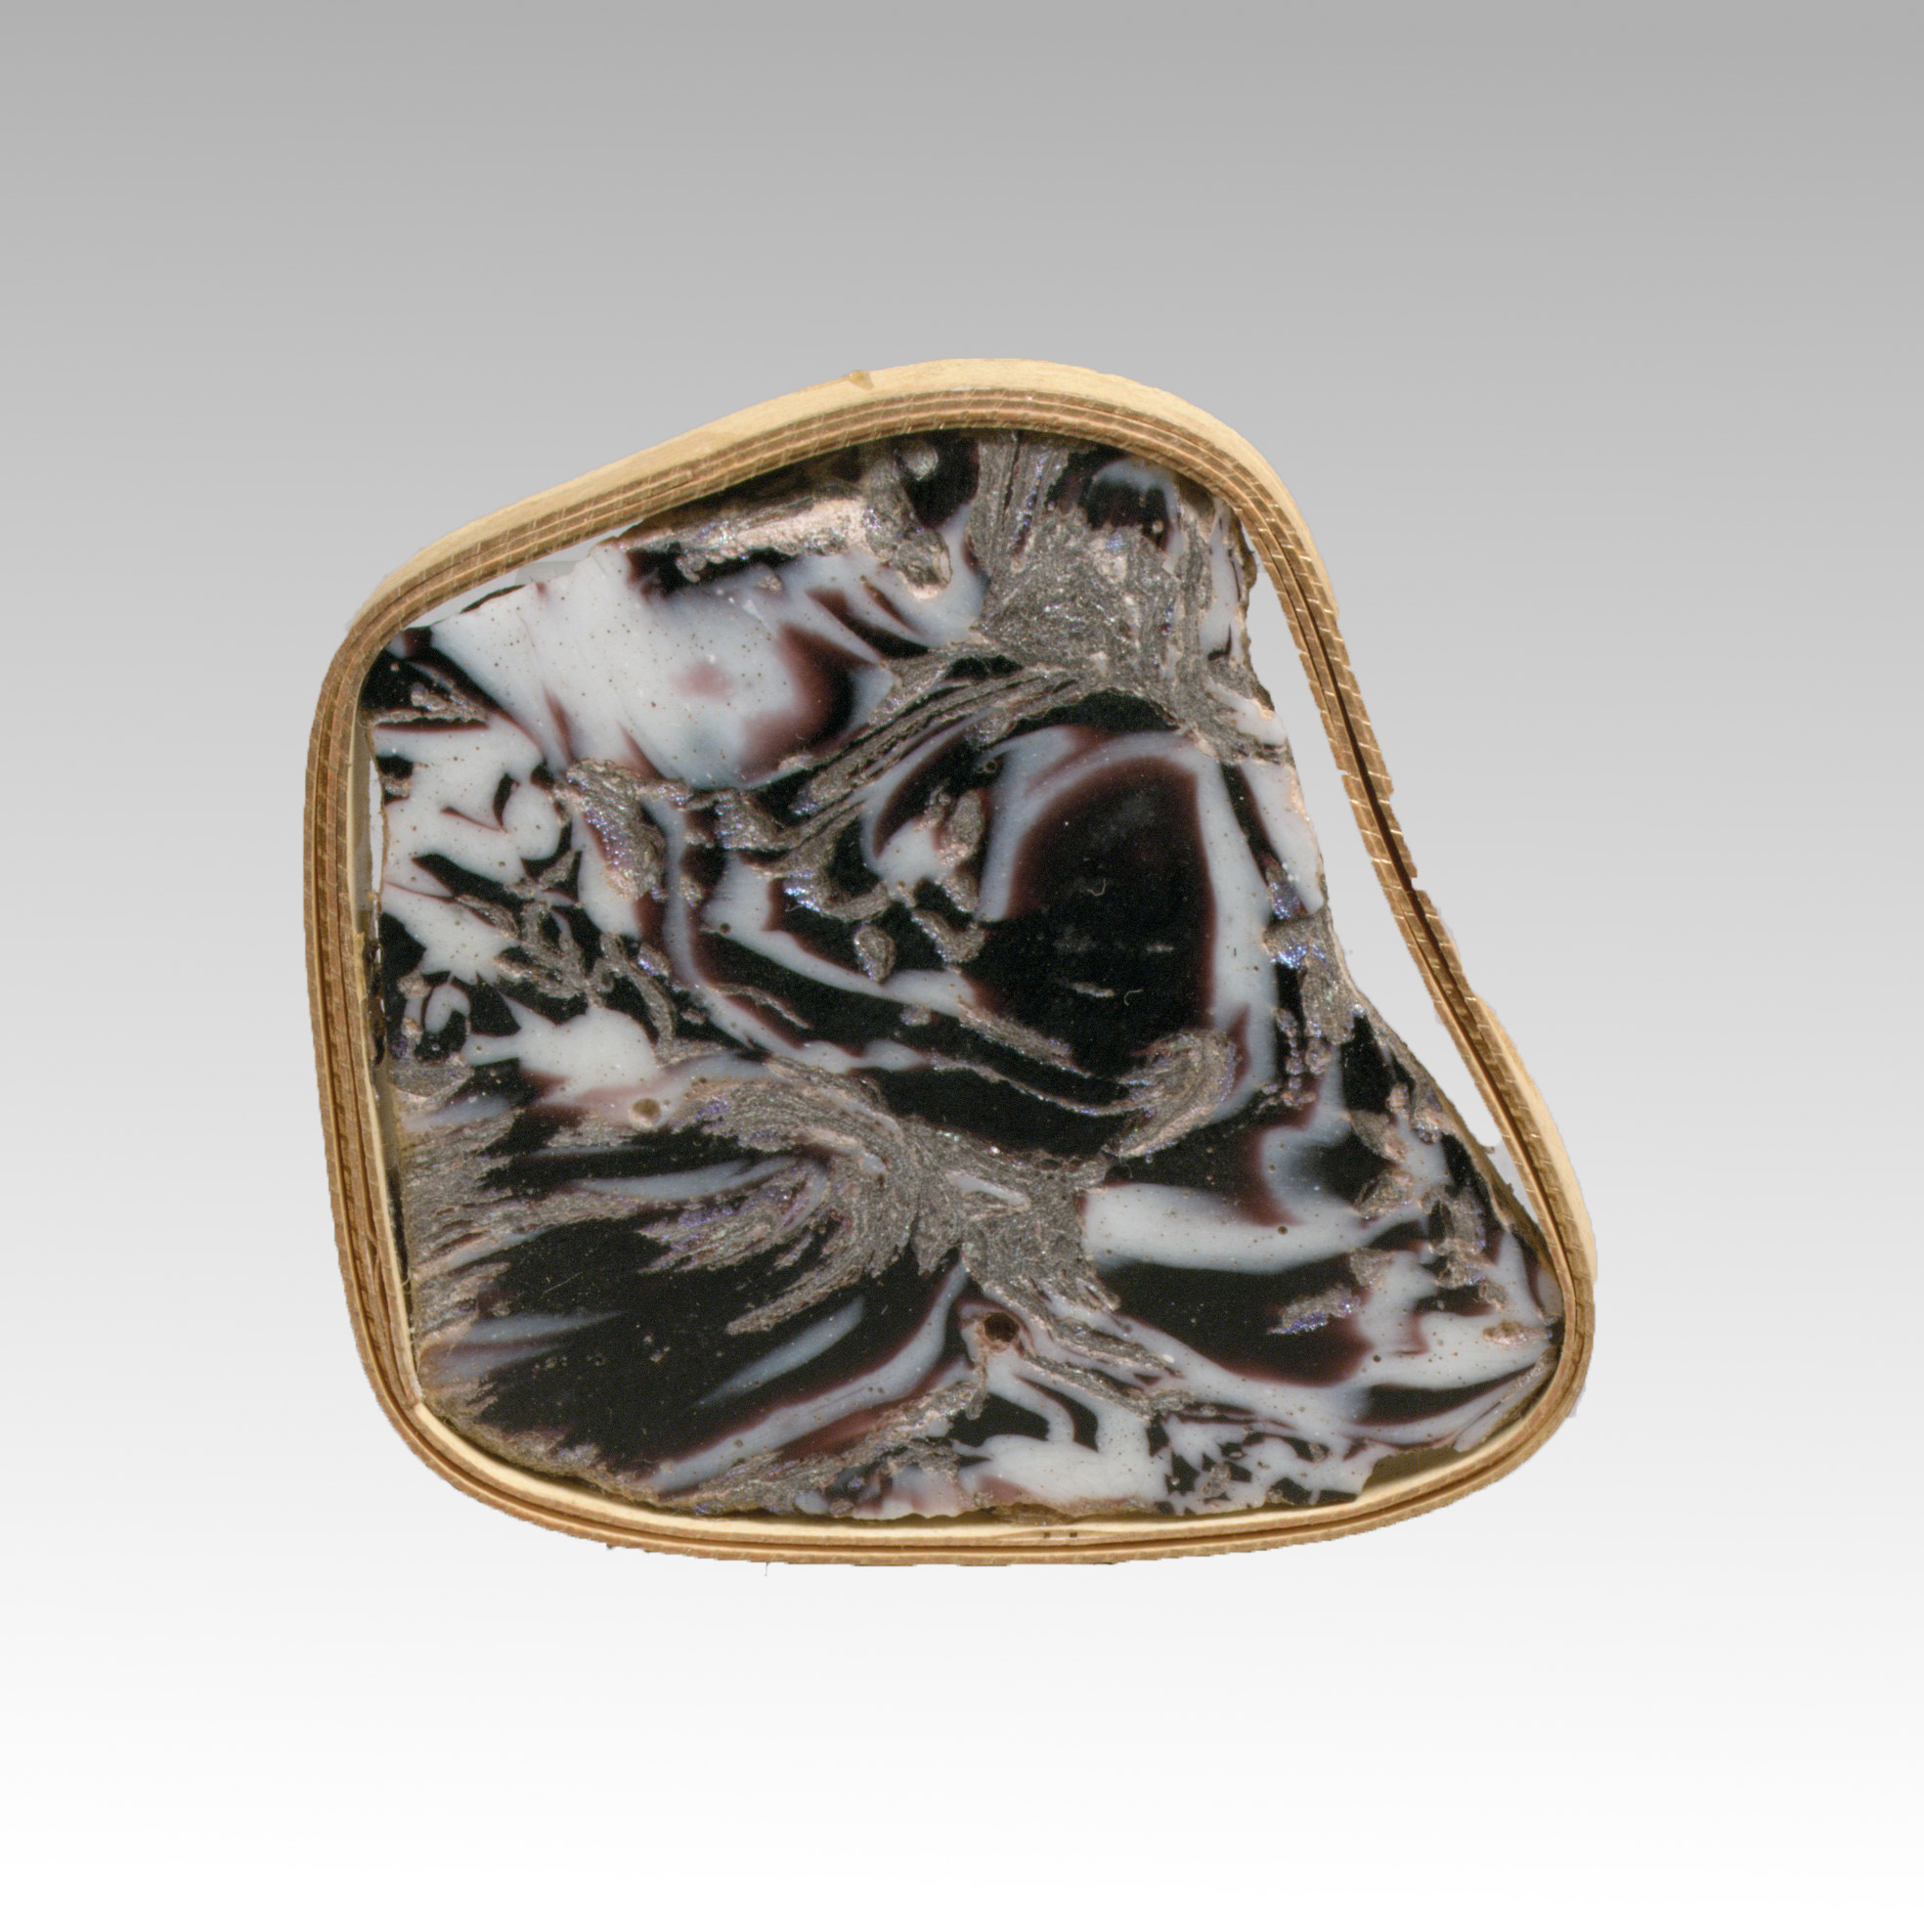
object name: fragment, mosaic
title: Glass mosaic inlay fragment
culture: roman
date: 34 BCE-33 CE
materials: glass